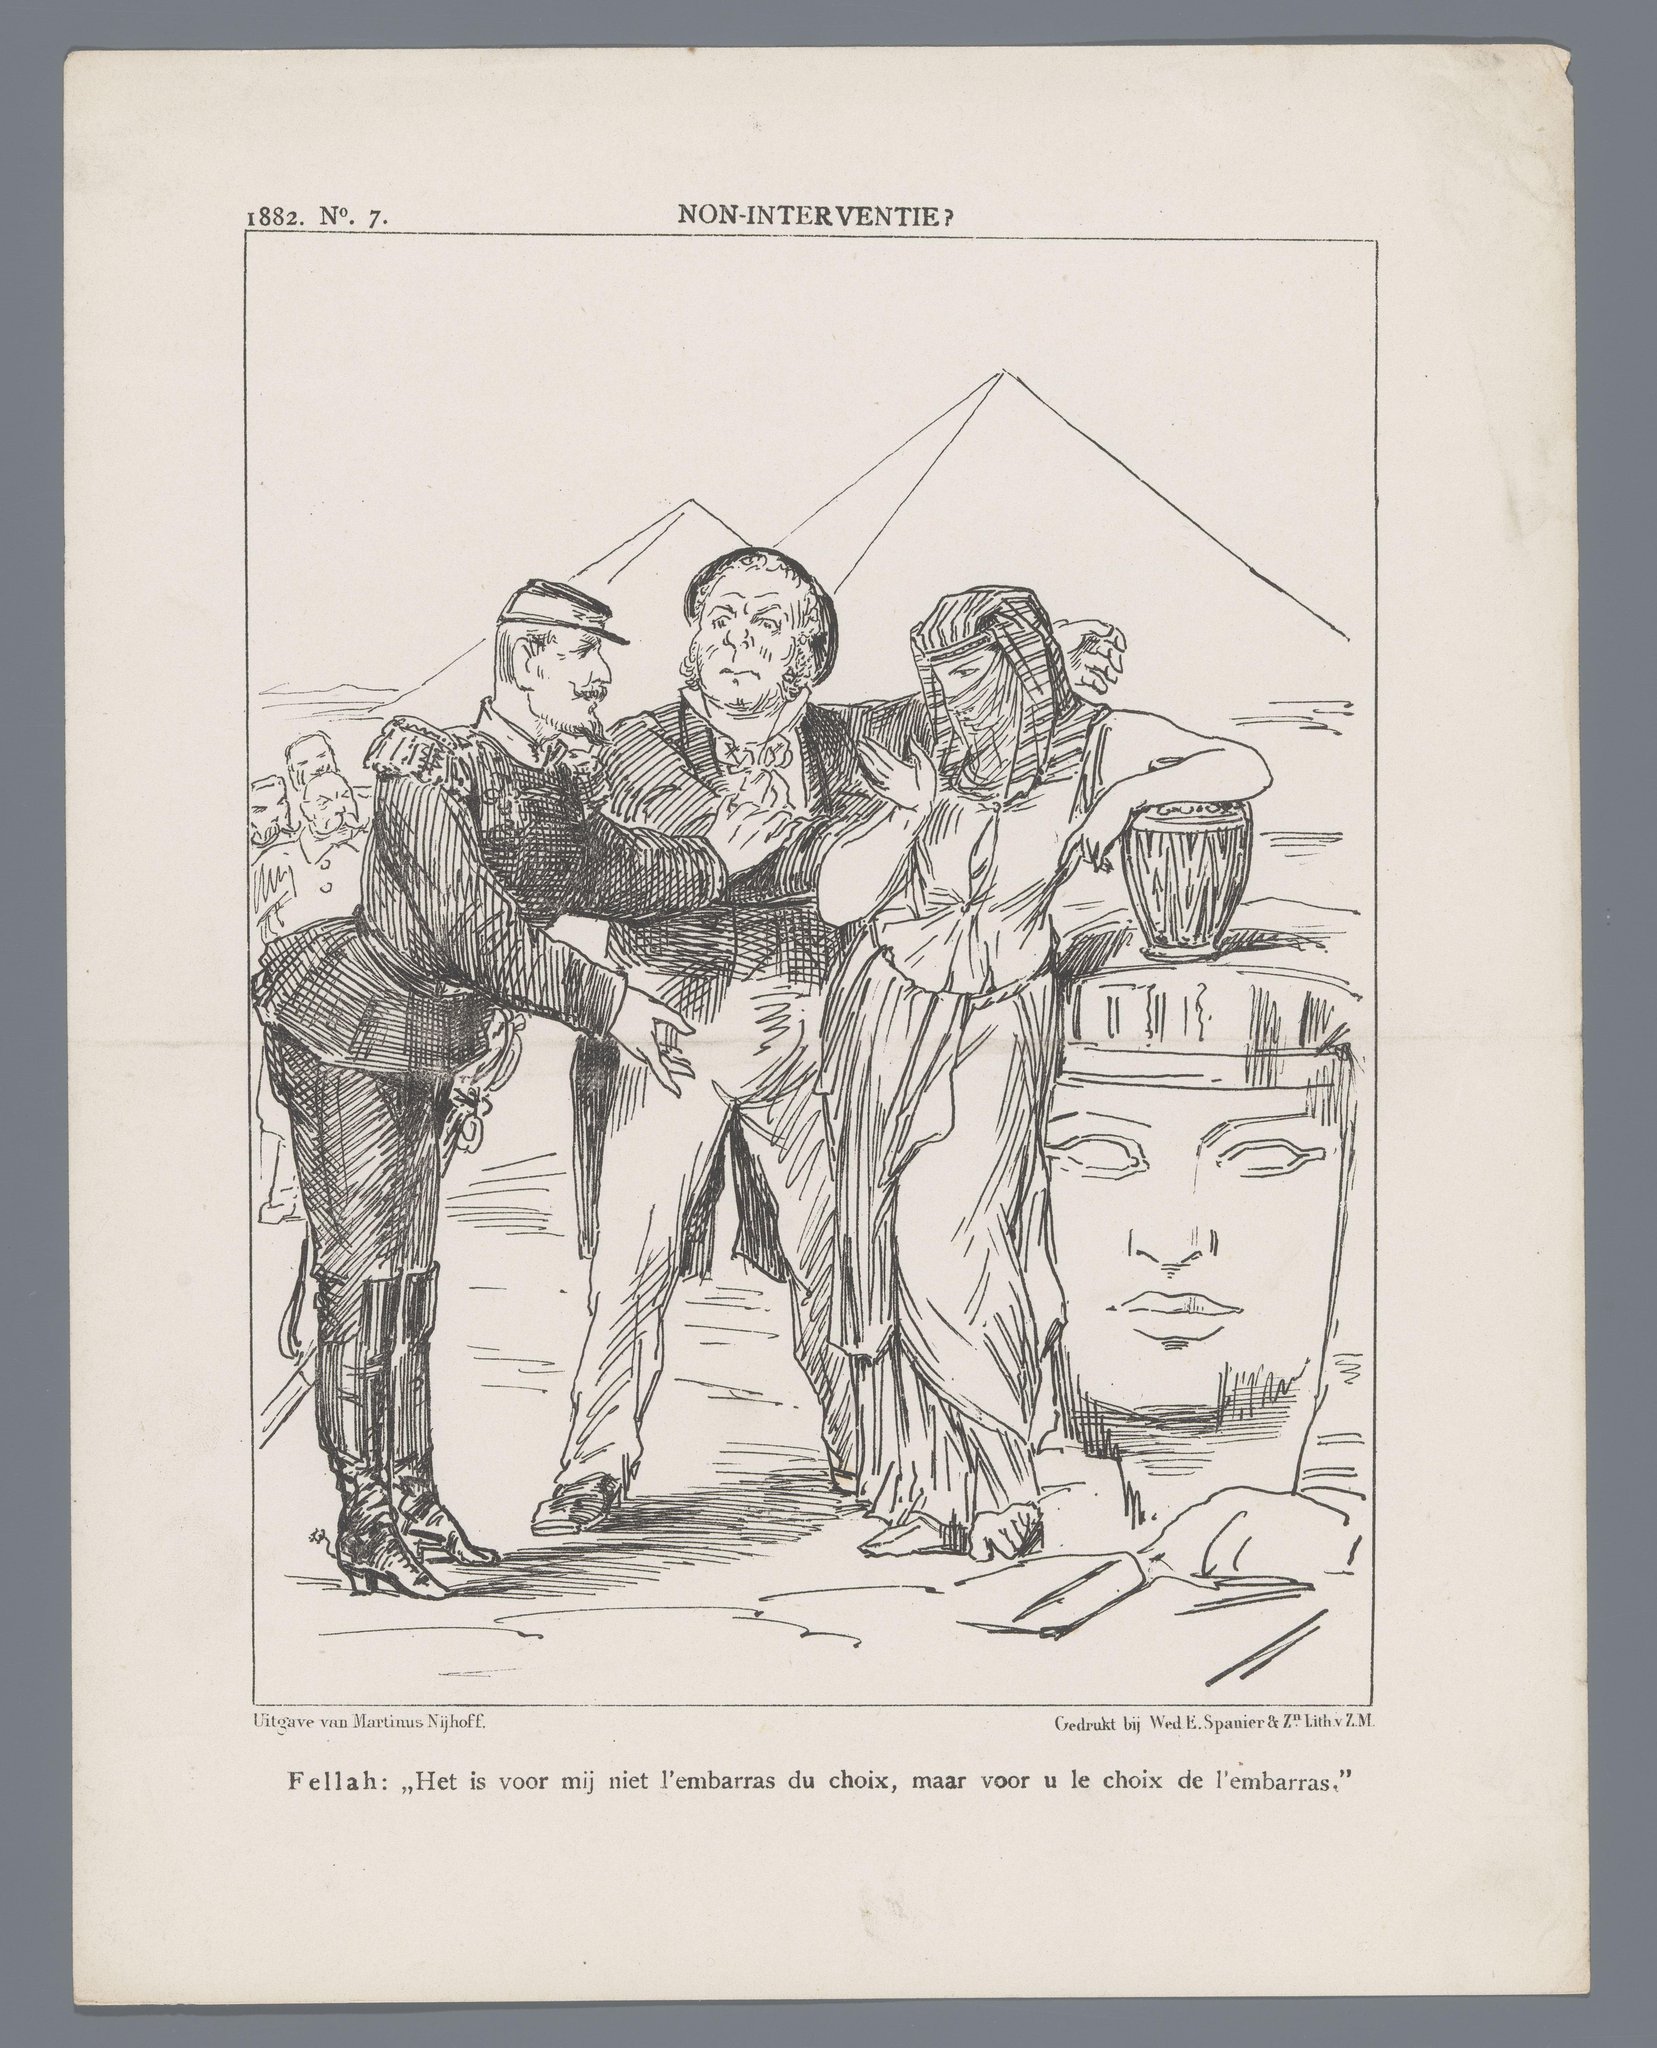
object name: cartoon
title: Non-interventie?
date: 1882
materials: paper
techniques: lithograph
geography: netherlands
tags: egypte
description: Politieke spotprent over Europese interventie in Egypte. Plaat verschenen bij het weekblad De Nederlandsche Spectator, nr. 7, 1882.